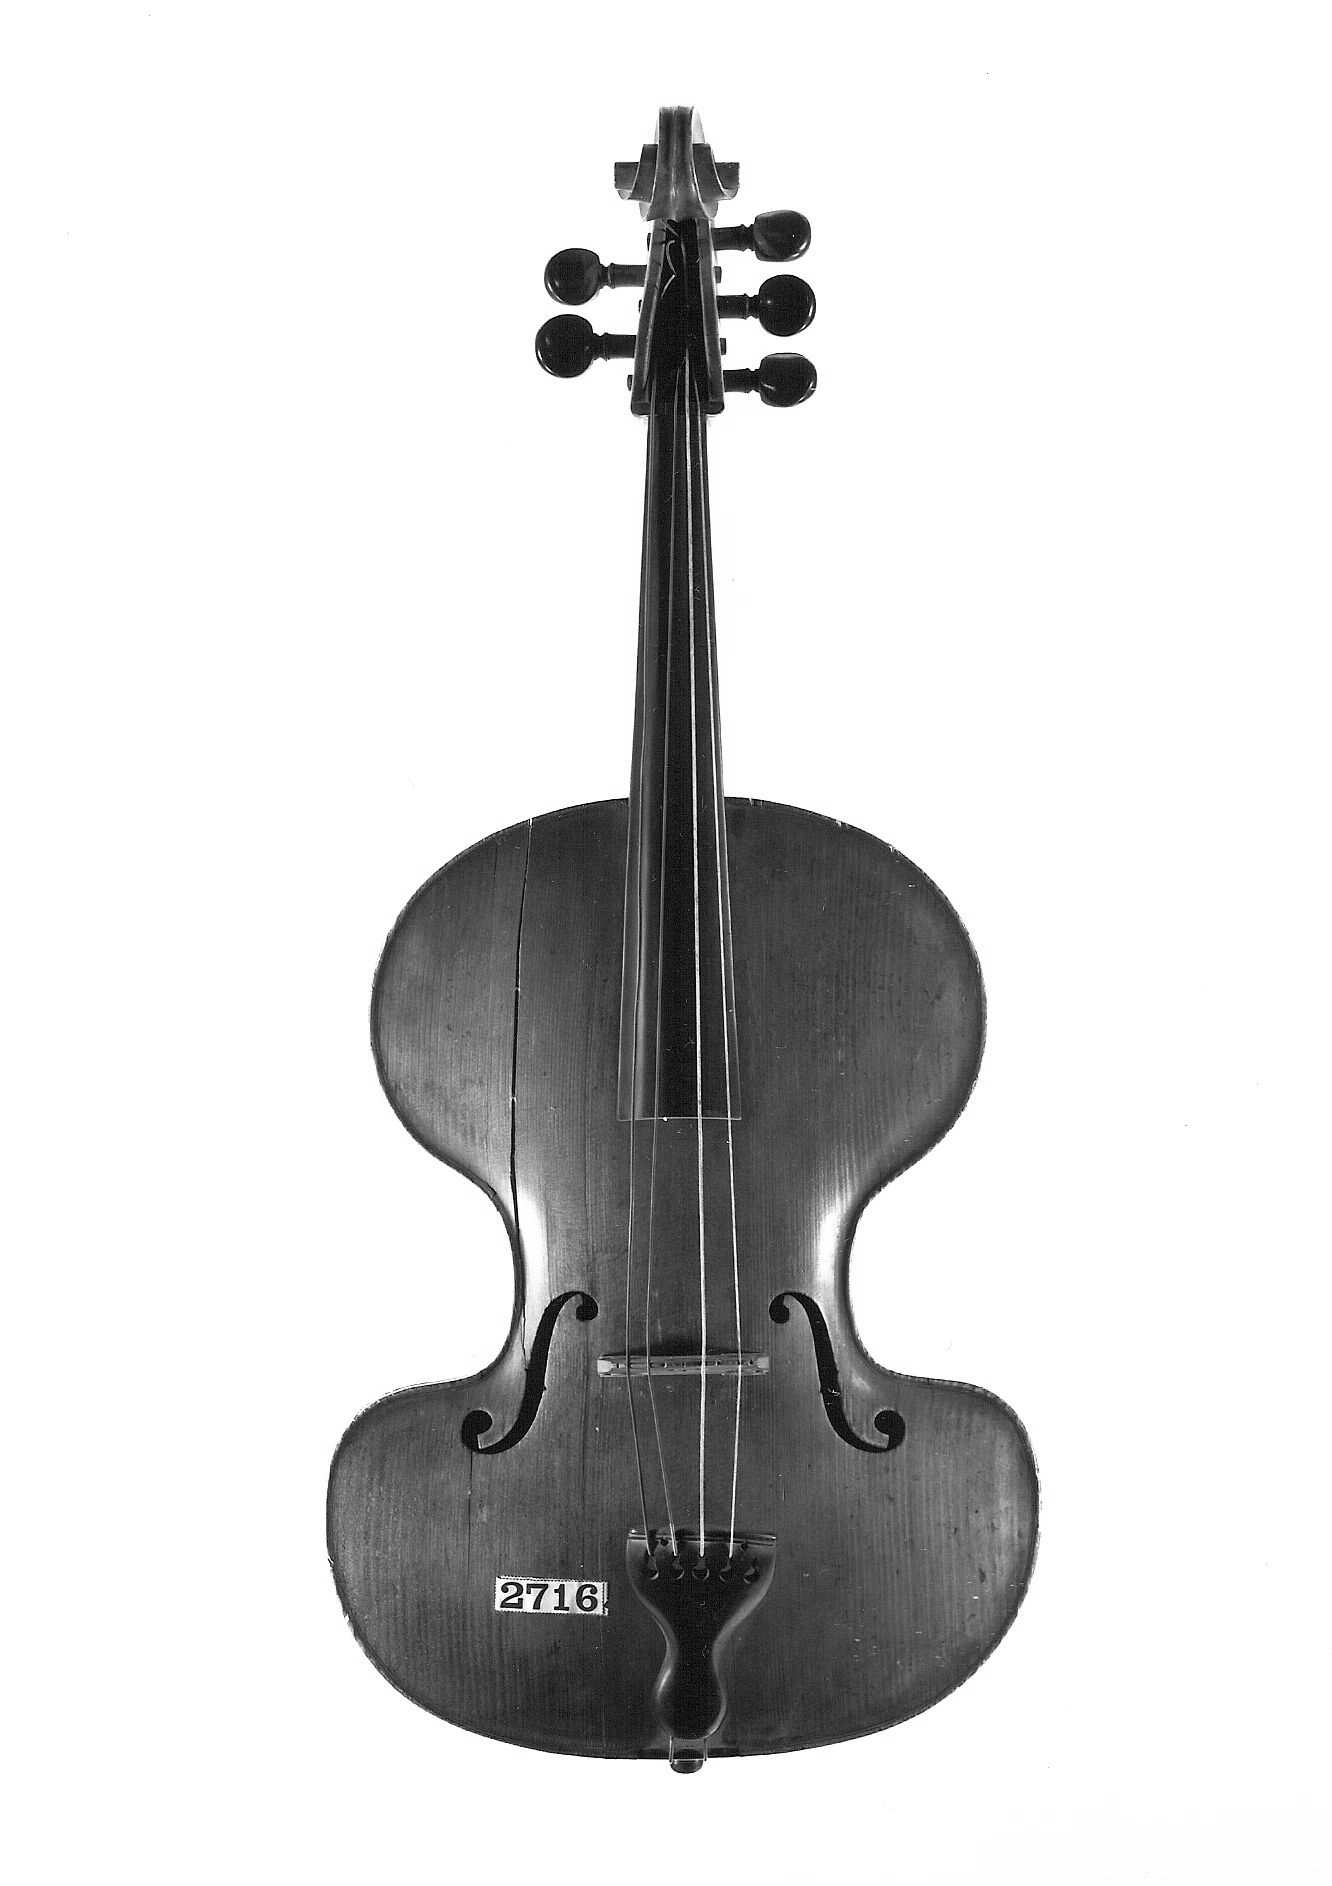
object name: viola pomposa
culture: bohemian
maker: josef klee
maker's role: maker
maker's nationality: german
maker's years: 1856-1893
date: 1801-1900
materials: wood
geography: bohemia